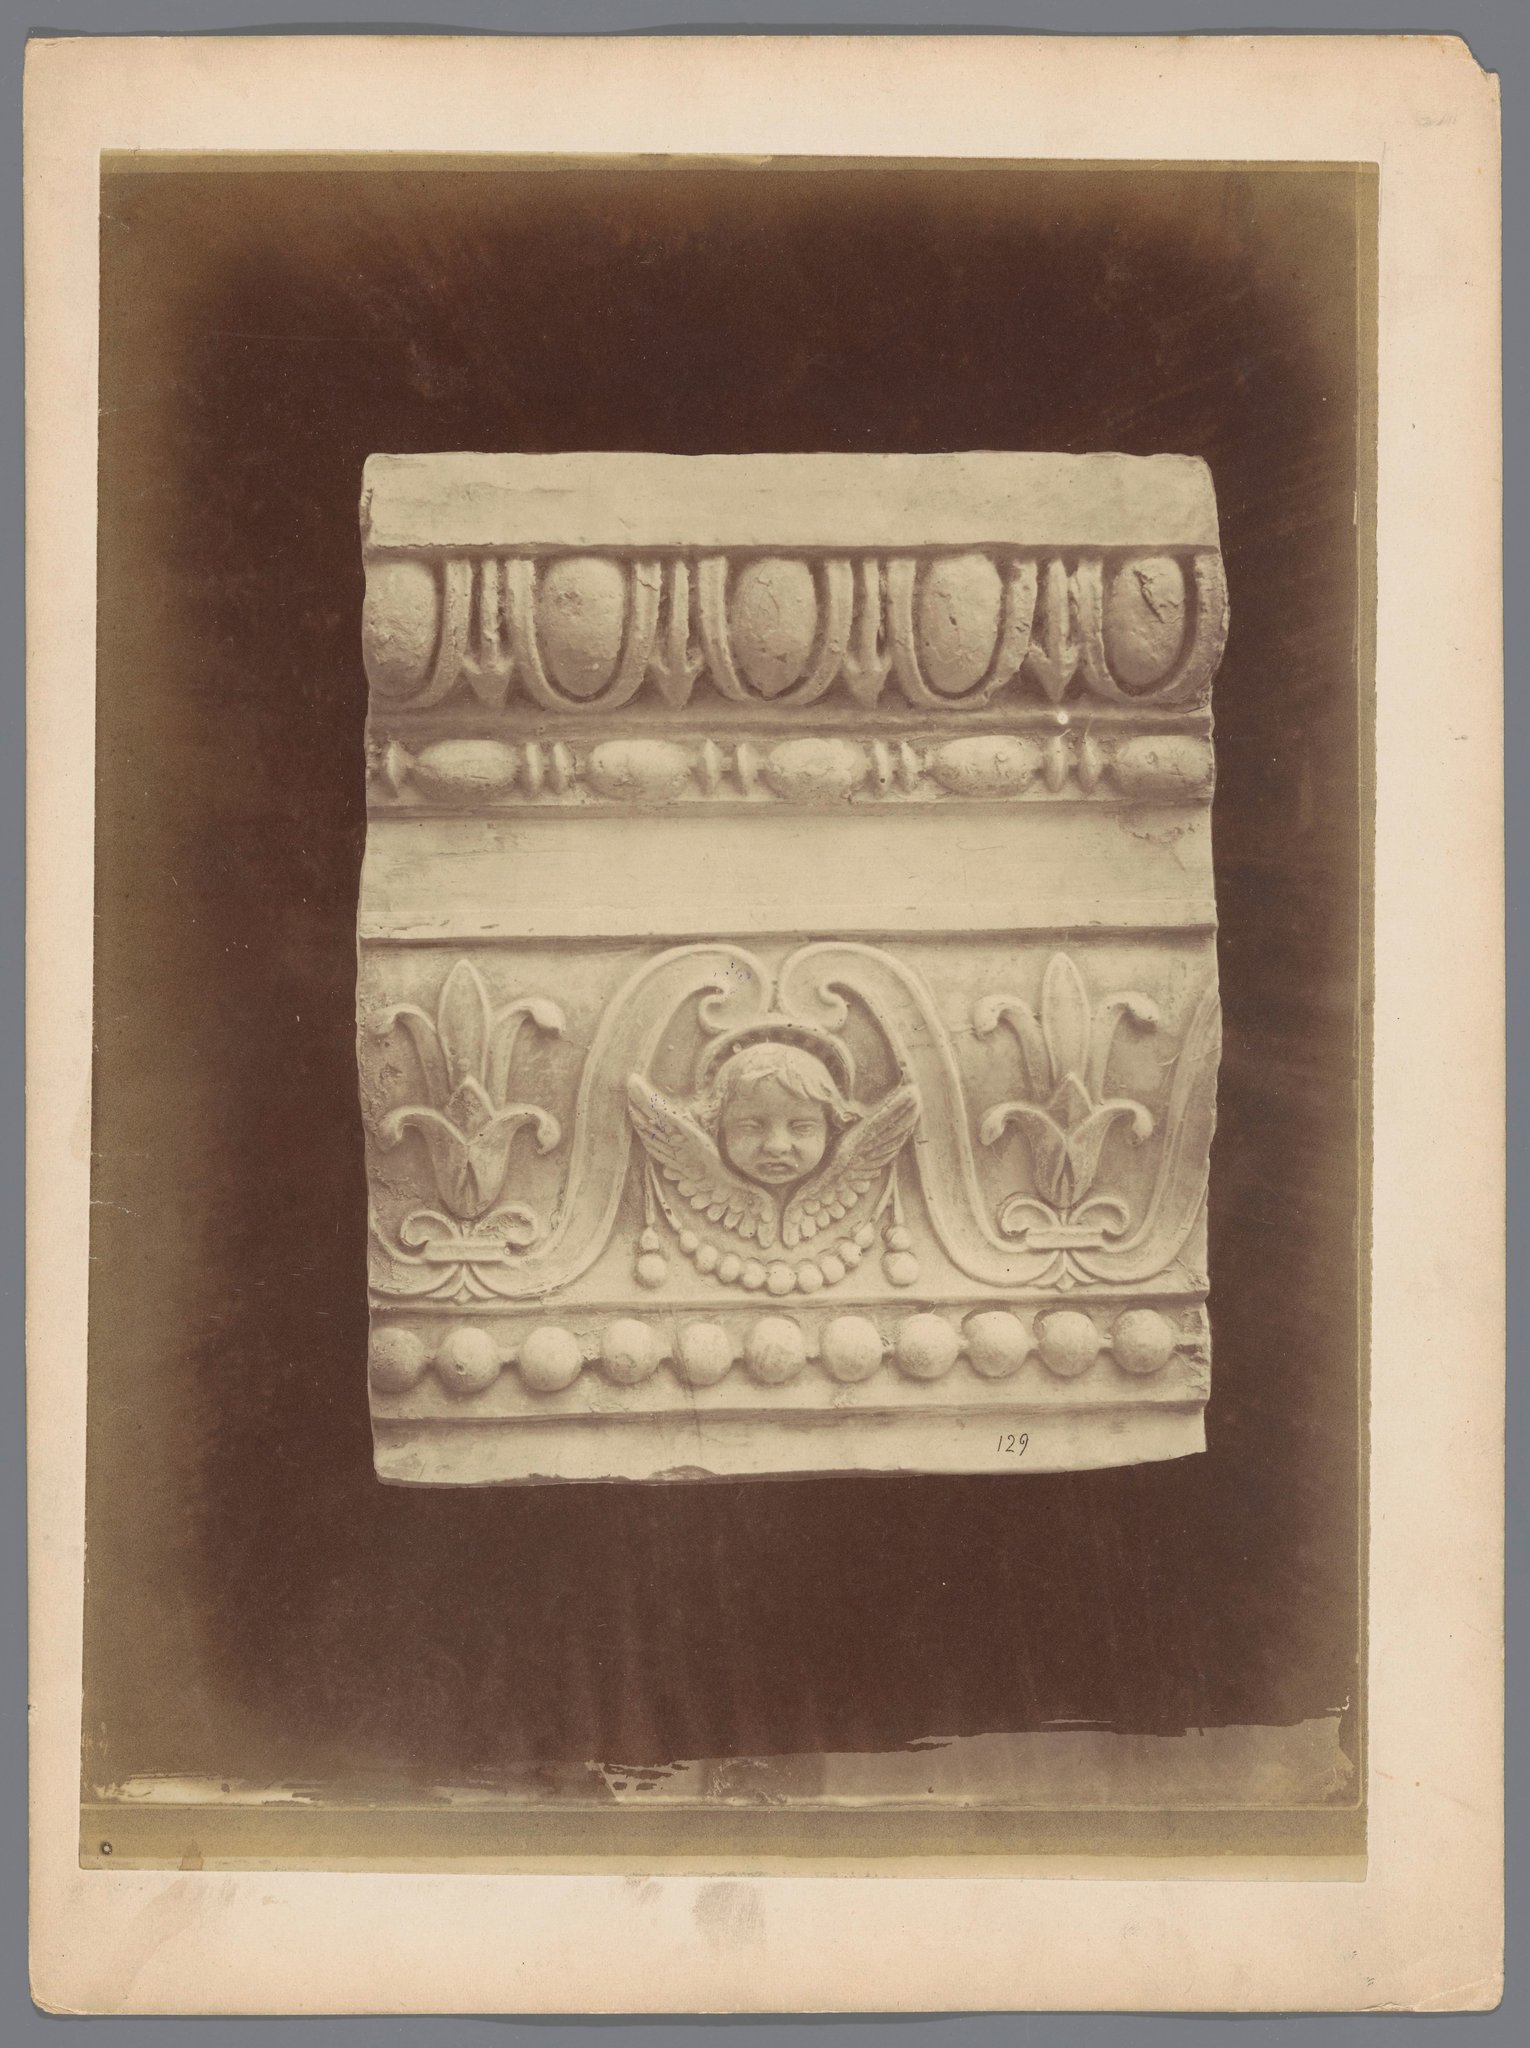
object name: photograph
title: Reliëf met een cherubijn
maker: gustave eugène chauffourier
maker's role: fotograaf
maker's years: 1845-1919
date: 1875-1900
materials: photographic support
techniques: albumen print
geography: rome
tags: cherubs, i.e. children's heads with wings, sculpture (+ relief ~ sculpture)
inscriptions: collector's mark: Lugt 3937, number: ‘129’